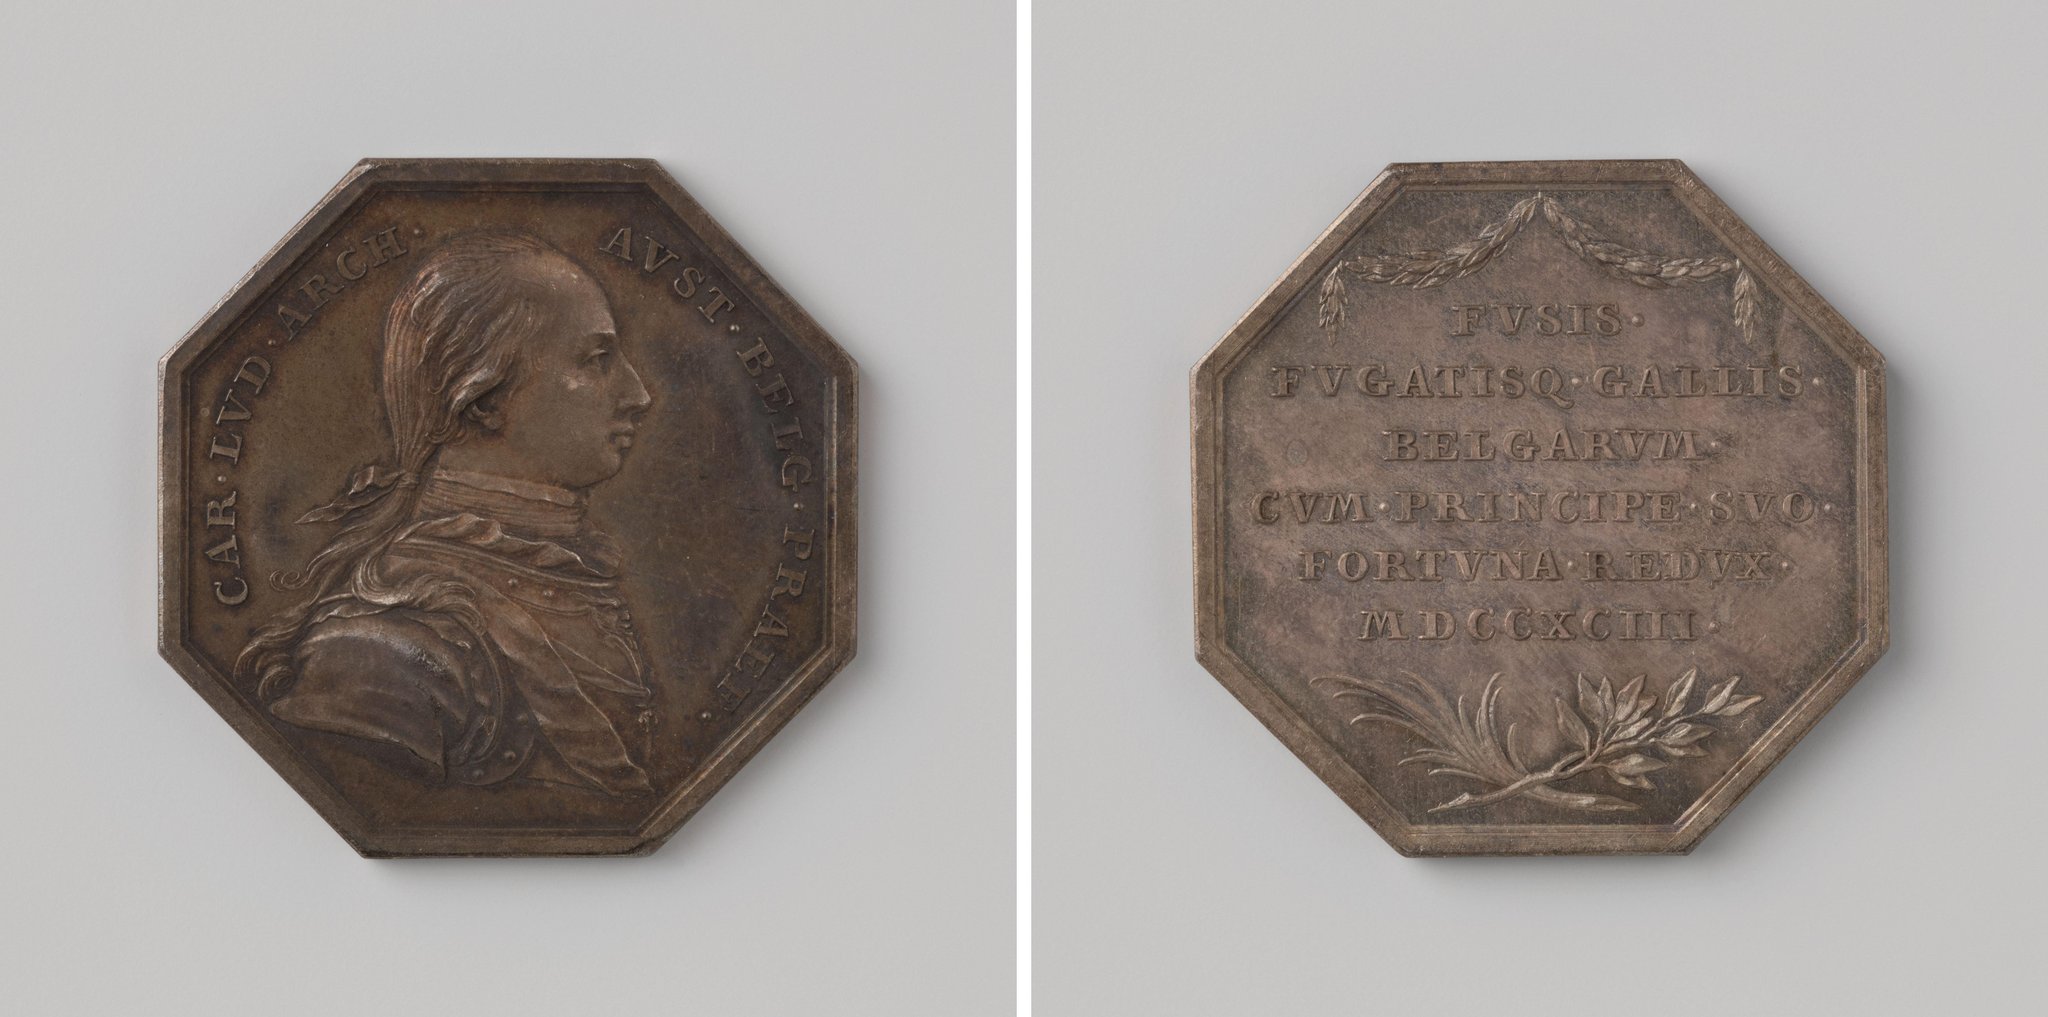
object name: history medal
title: Karel Lodewijk Johan, landvoogd der zuidelijke Nederlanden verdrijft de Fransen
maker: Anonymous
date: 1793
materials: silver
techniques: striking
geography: belgium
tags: vienna, belgium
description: Zilveren achthoekige penning. Voorzijde: borststuk man binnen omschrift. Keerzijde: opschrift tussen bloemenguirlande en gekruiste palm- en olijftak